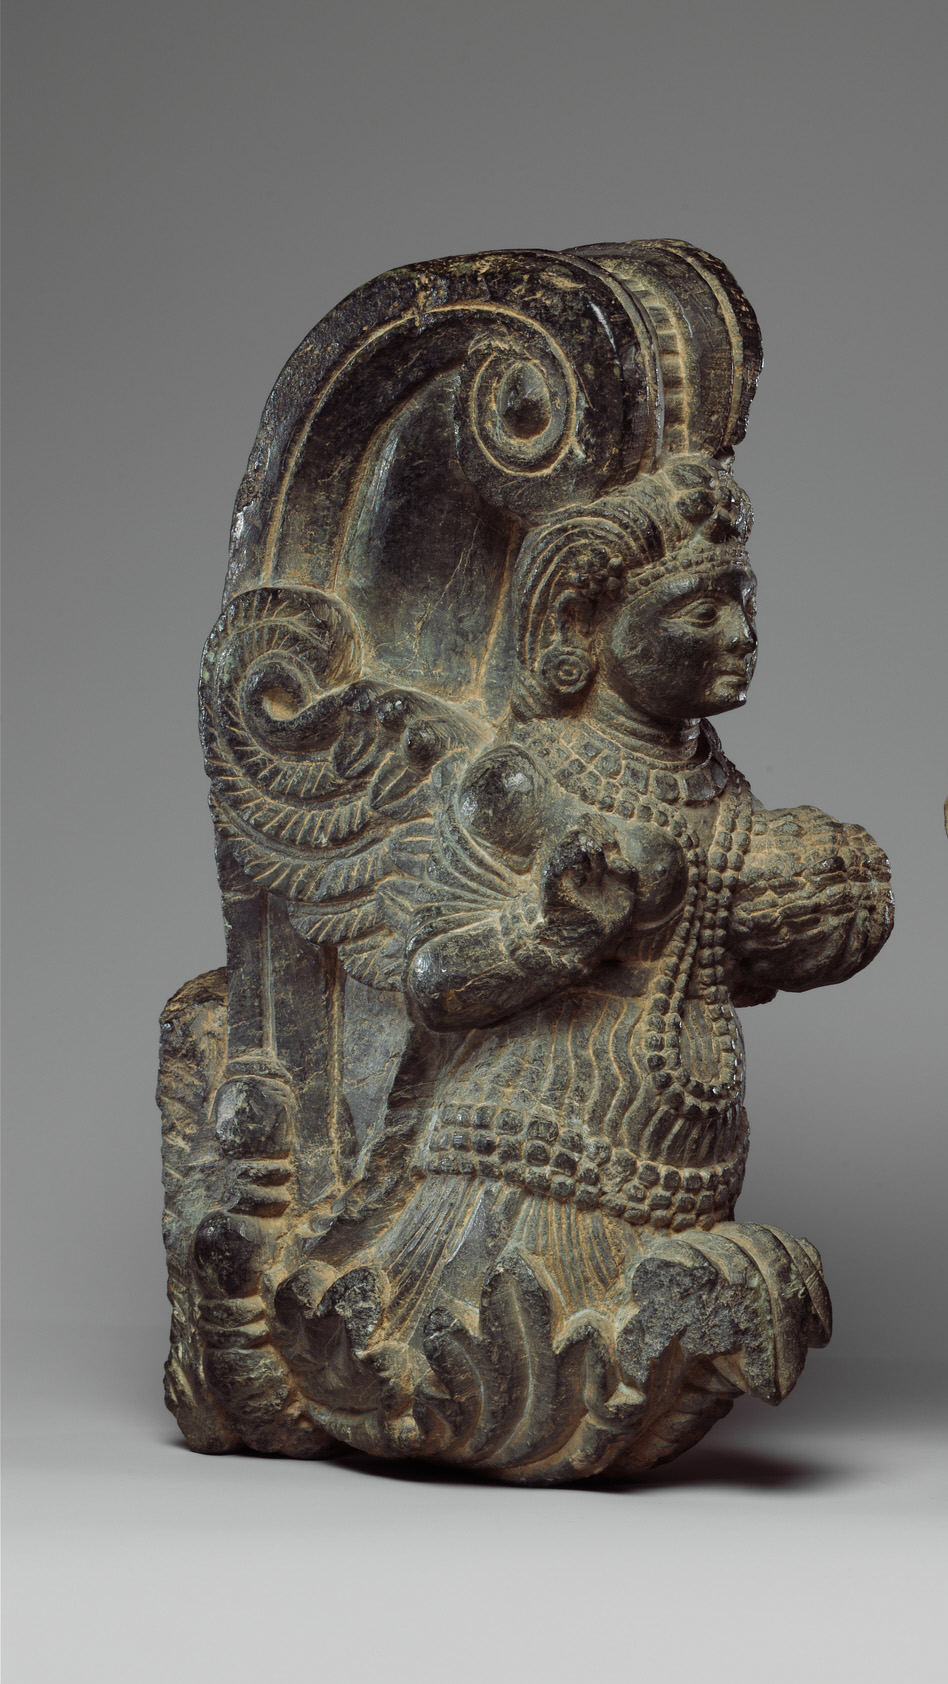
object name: garland holder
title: Garland Holder with a Winged Celestial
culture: gandhara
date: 34-66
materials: stone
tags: gandhara